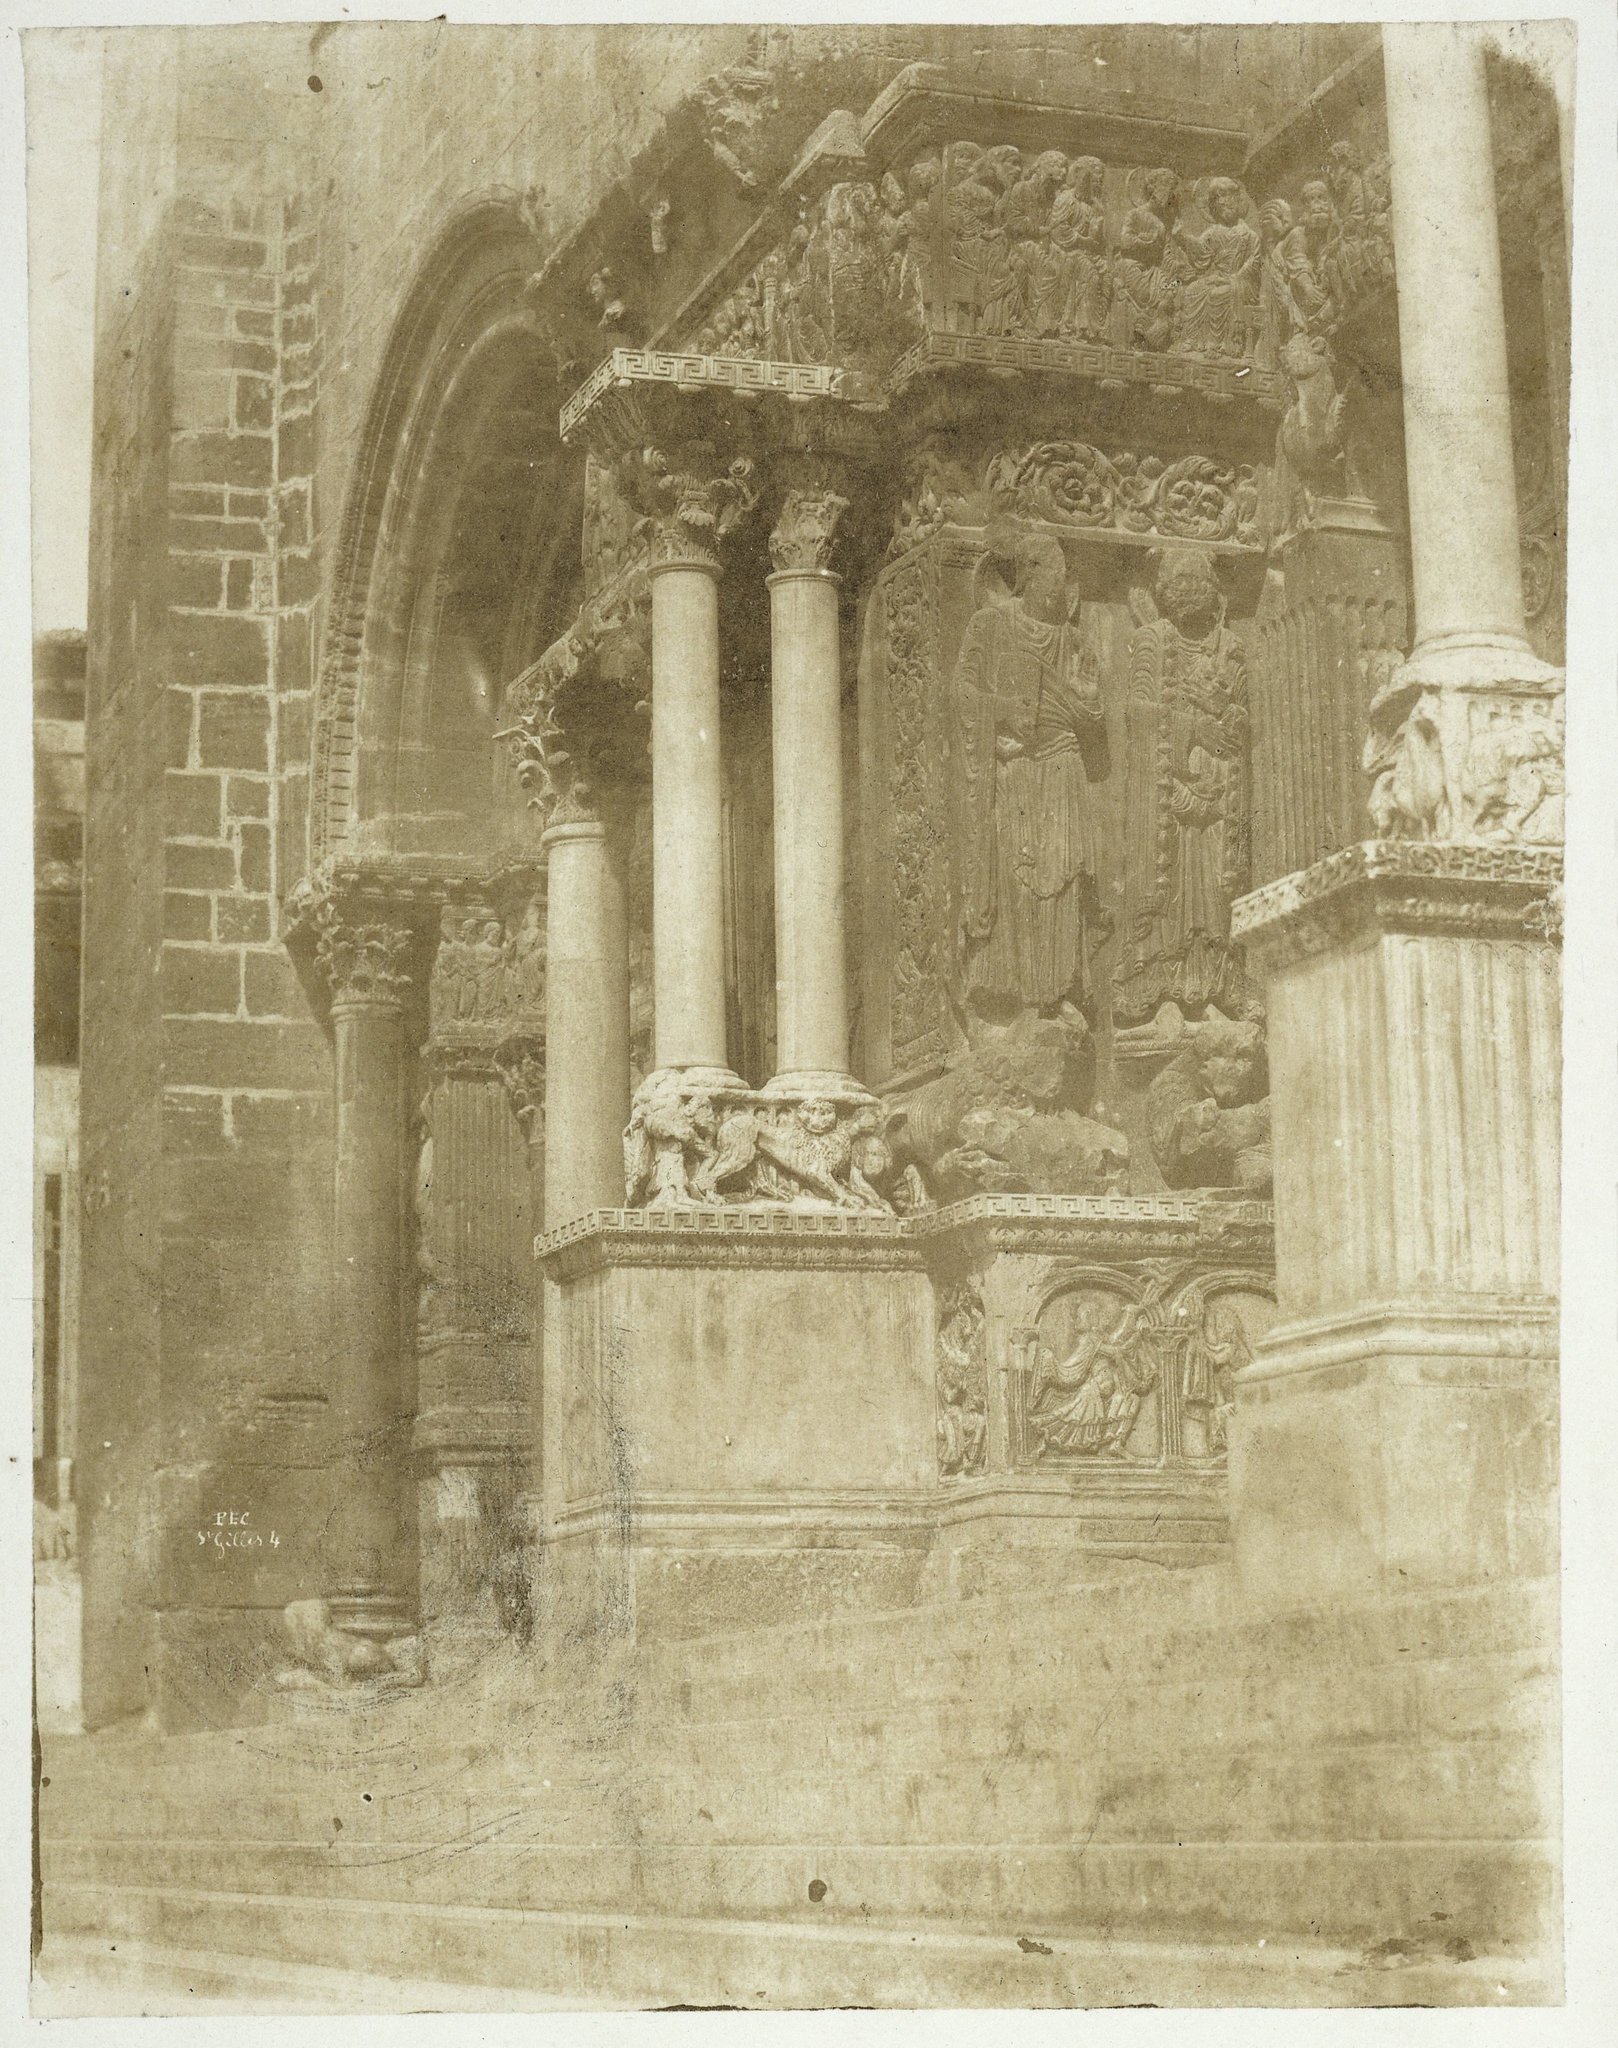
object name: photograph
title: Portaal van de kerk te Saint-Gilles-du-Gard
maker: emile pecarrère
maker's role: advocaat, fotograaf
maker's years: 1816-1904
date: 1850-1855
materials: cardboard, paper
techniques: salted paper print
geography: saint-gilles-du-gard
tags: parts of church exterior and annexes: portal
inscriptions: signature: ‘PEC/ St Gilles 4’